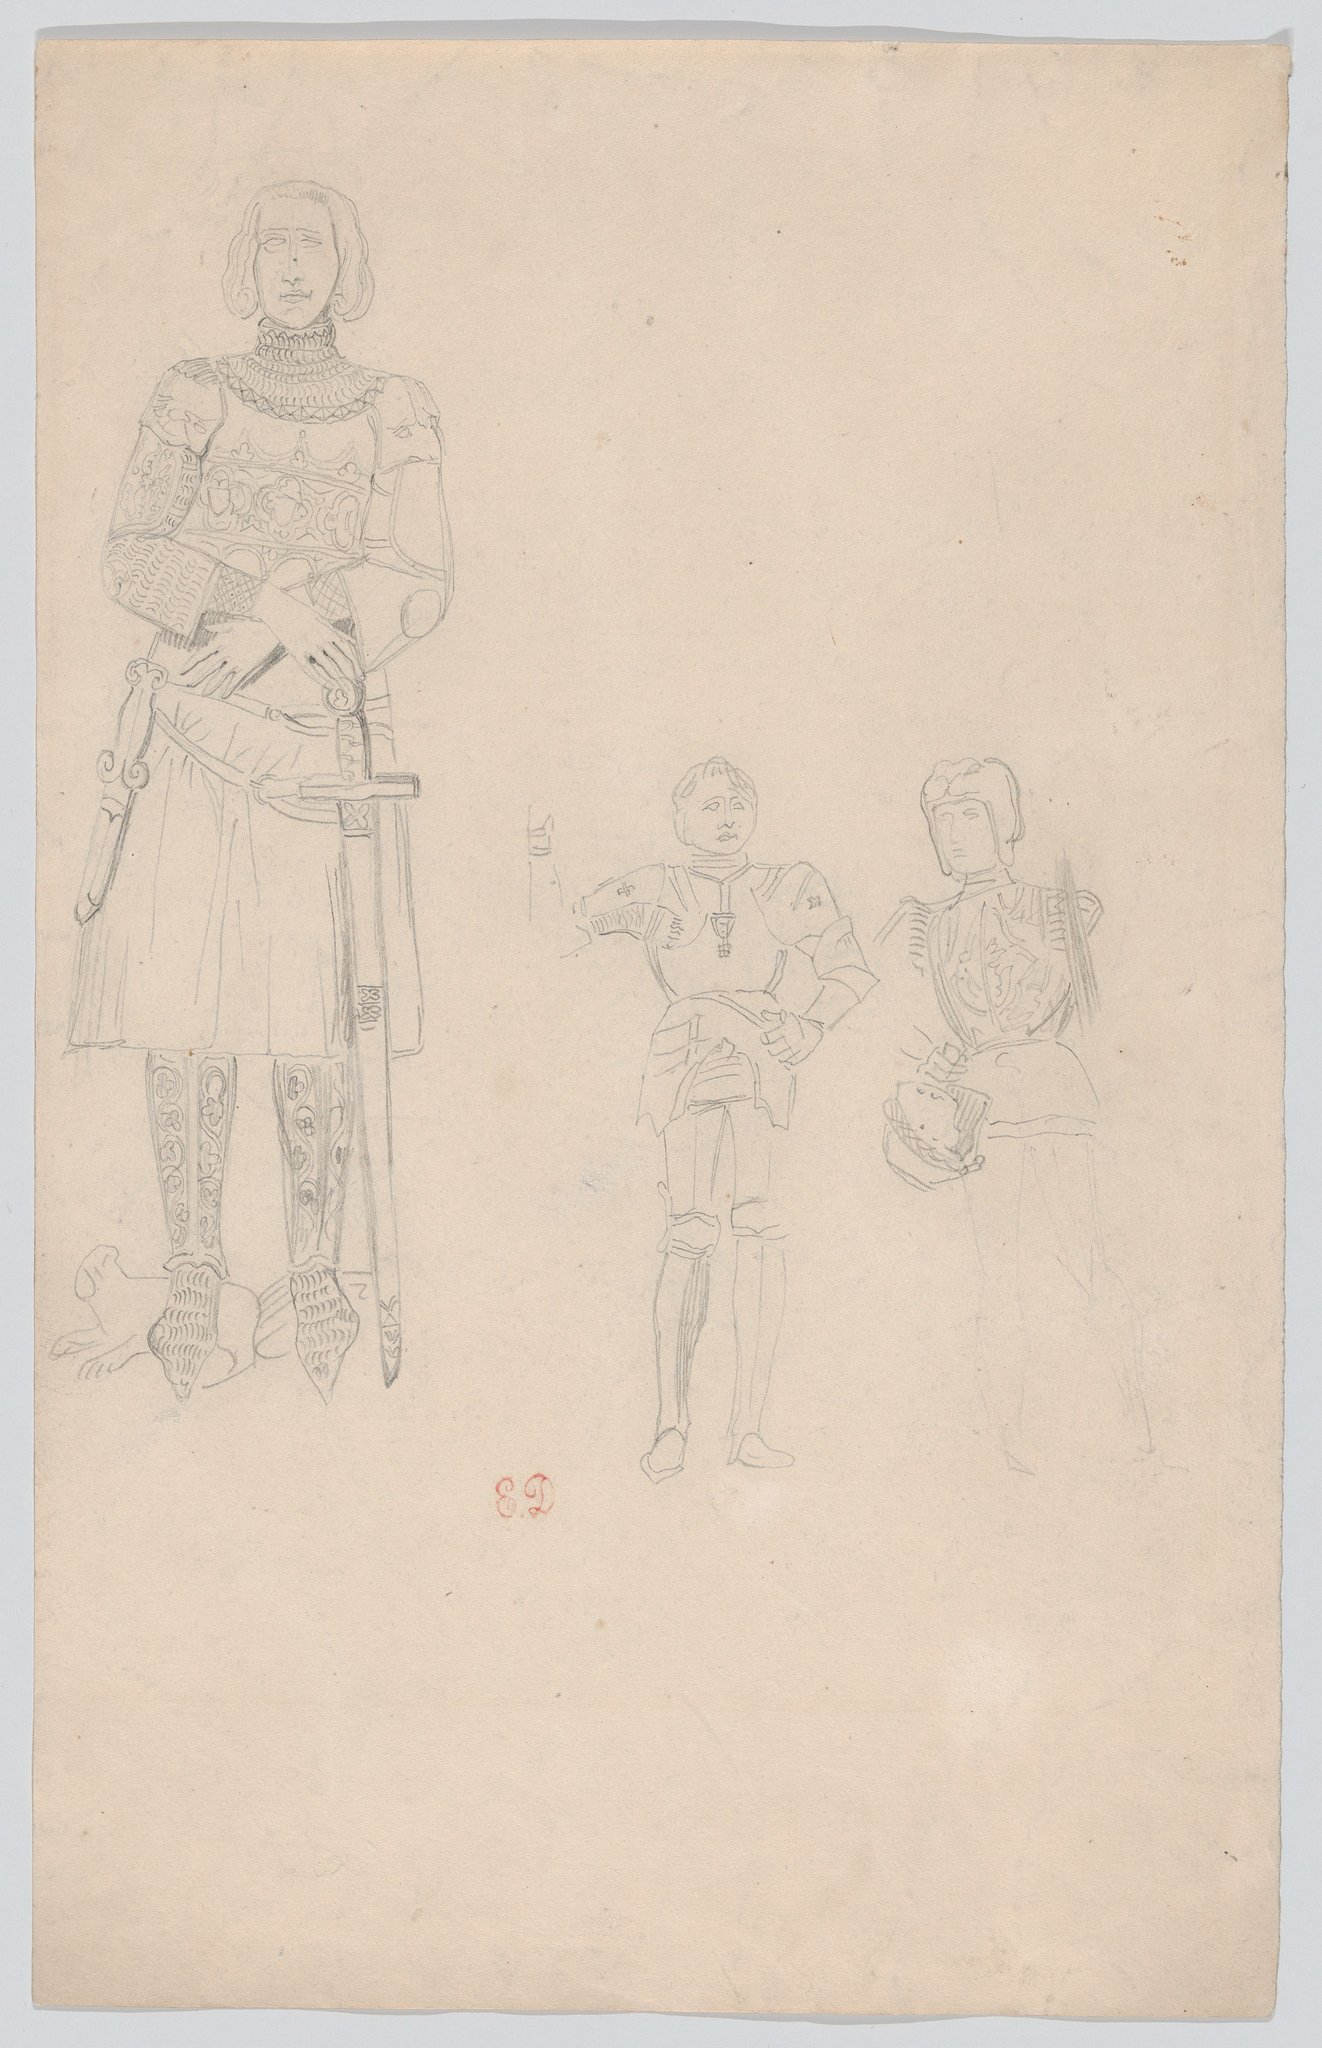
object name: drawing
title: Studies of Armored Figures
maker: eugène delacroix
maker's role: artist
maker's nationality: french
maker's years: 1798-1863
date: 1825-1830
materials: graphite